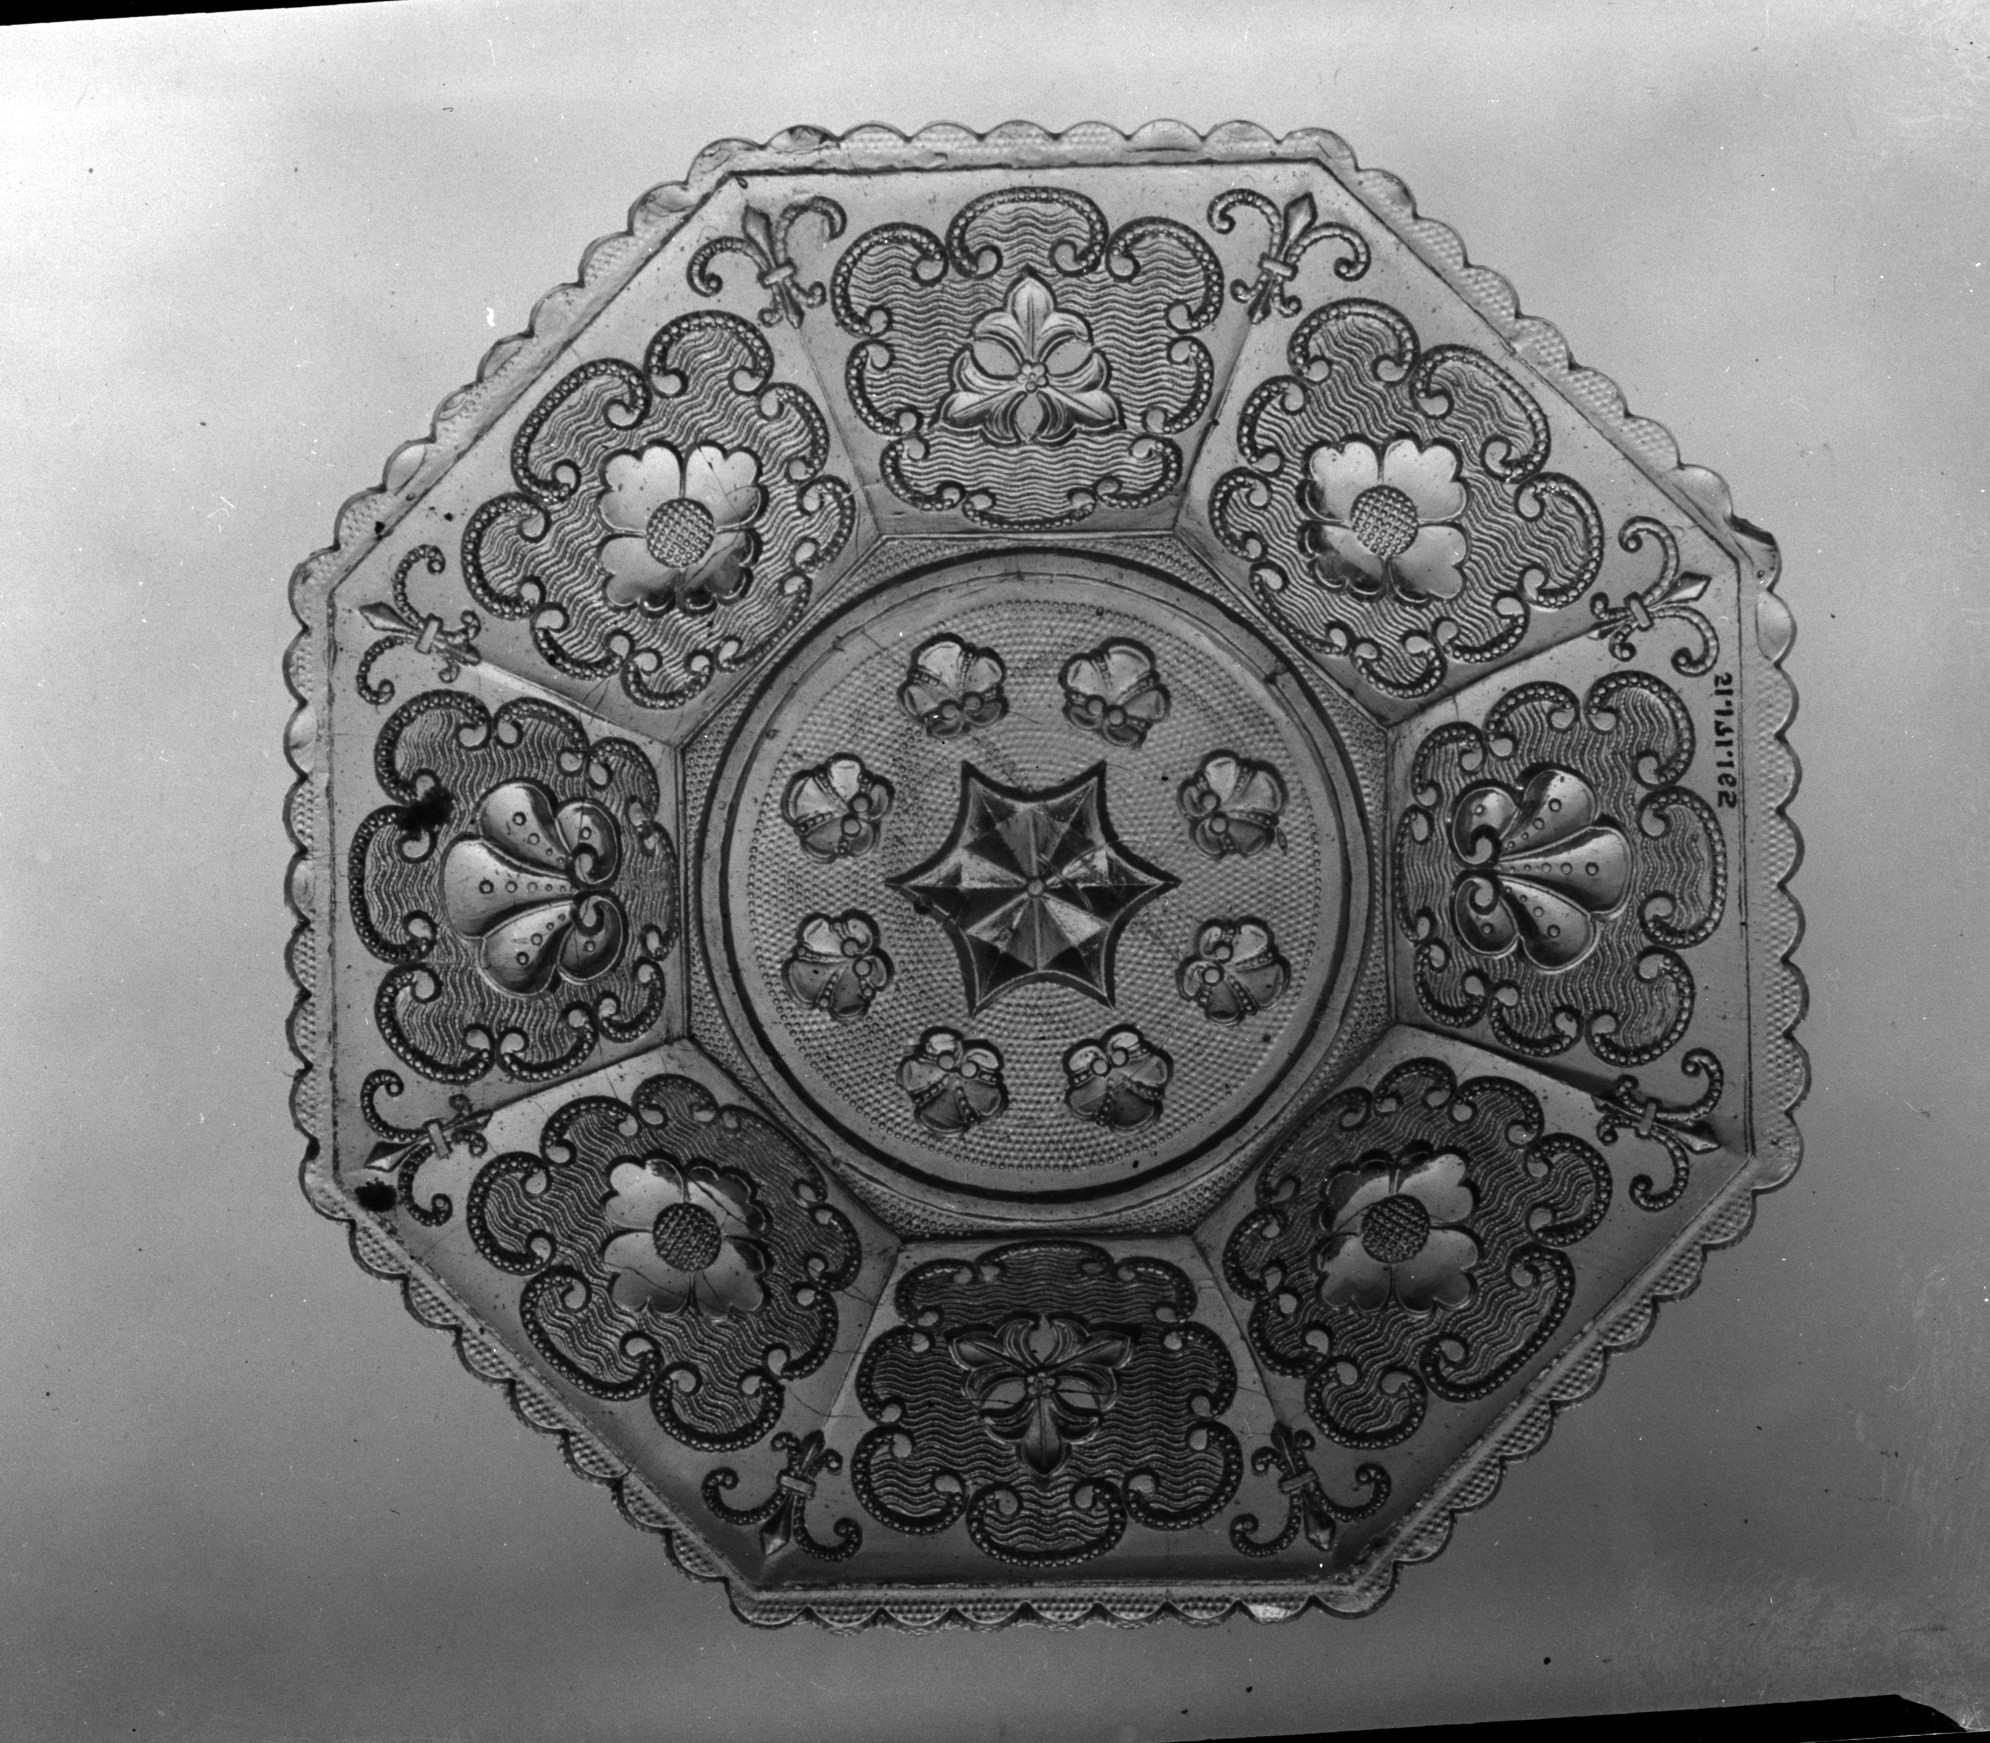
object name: dish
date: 1830-1900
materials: glass